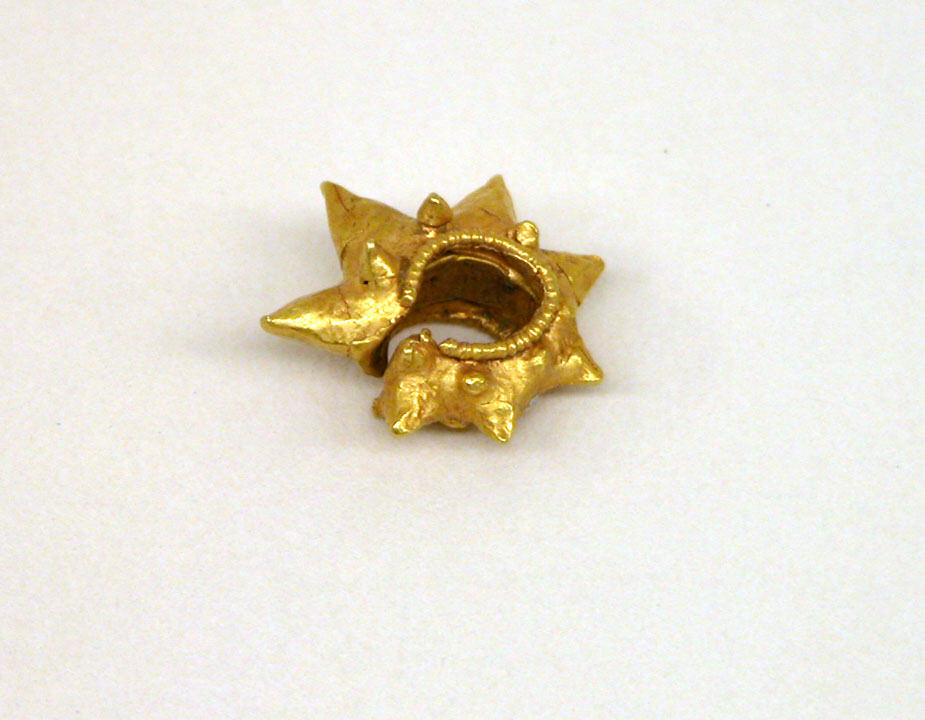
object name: ear clip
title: Pair of Ear Clips in the Shape of a Starfruit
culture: indonesian, javanese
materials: gold